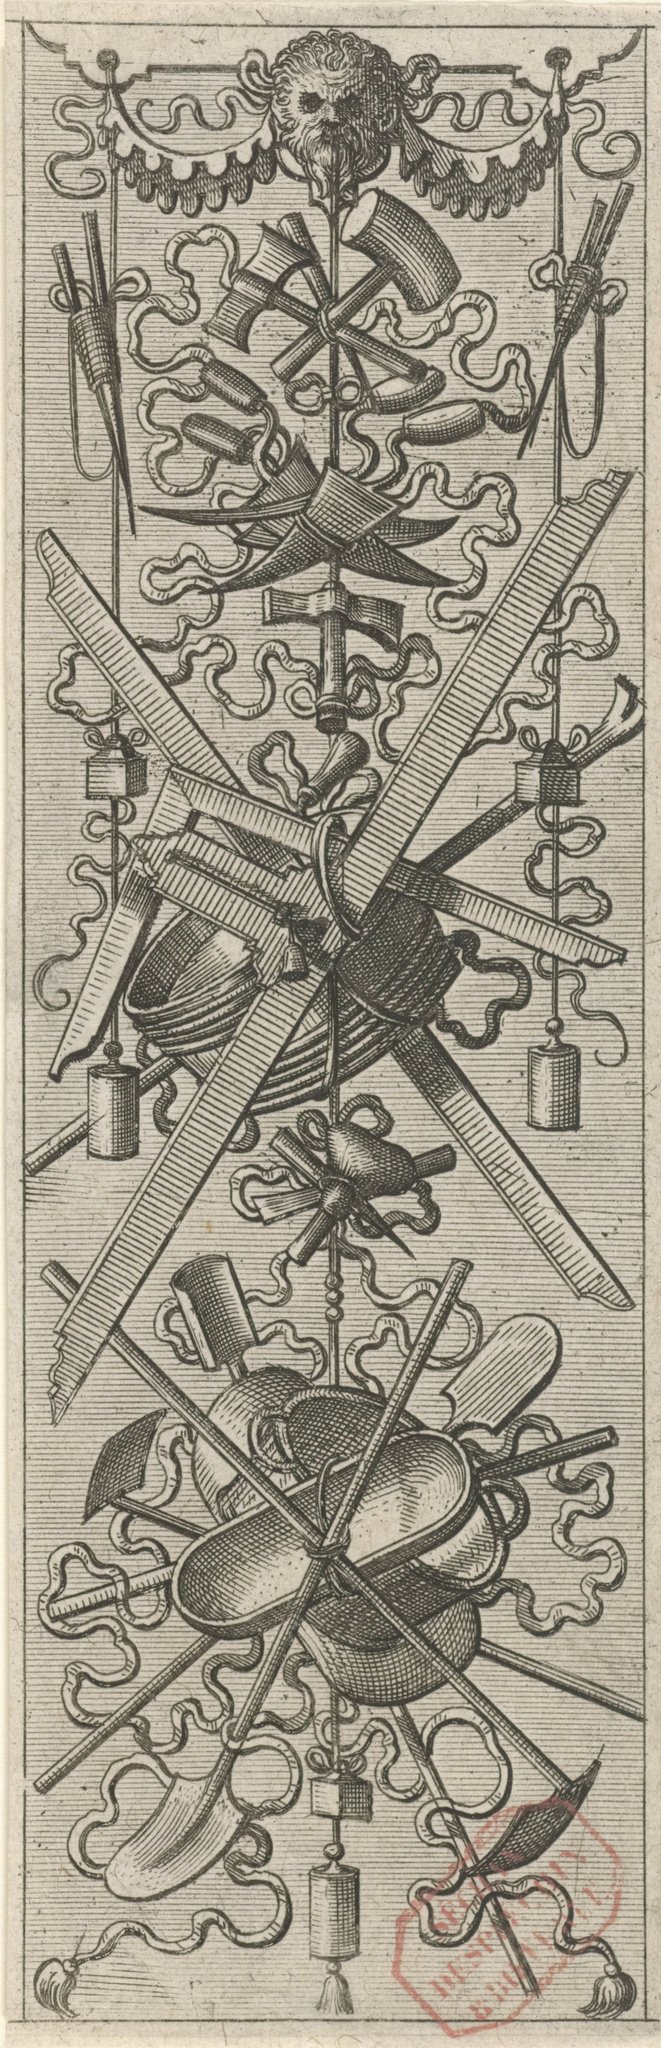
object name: print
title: Panoplia sev armamentarium…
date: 1572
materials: paper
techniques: etching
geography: netherlands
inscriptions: collector's mark: Lugt 2275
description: Uit serie, bestaande uit een titelblad en 16 bladen.